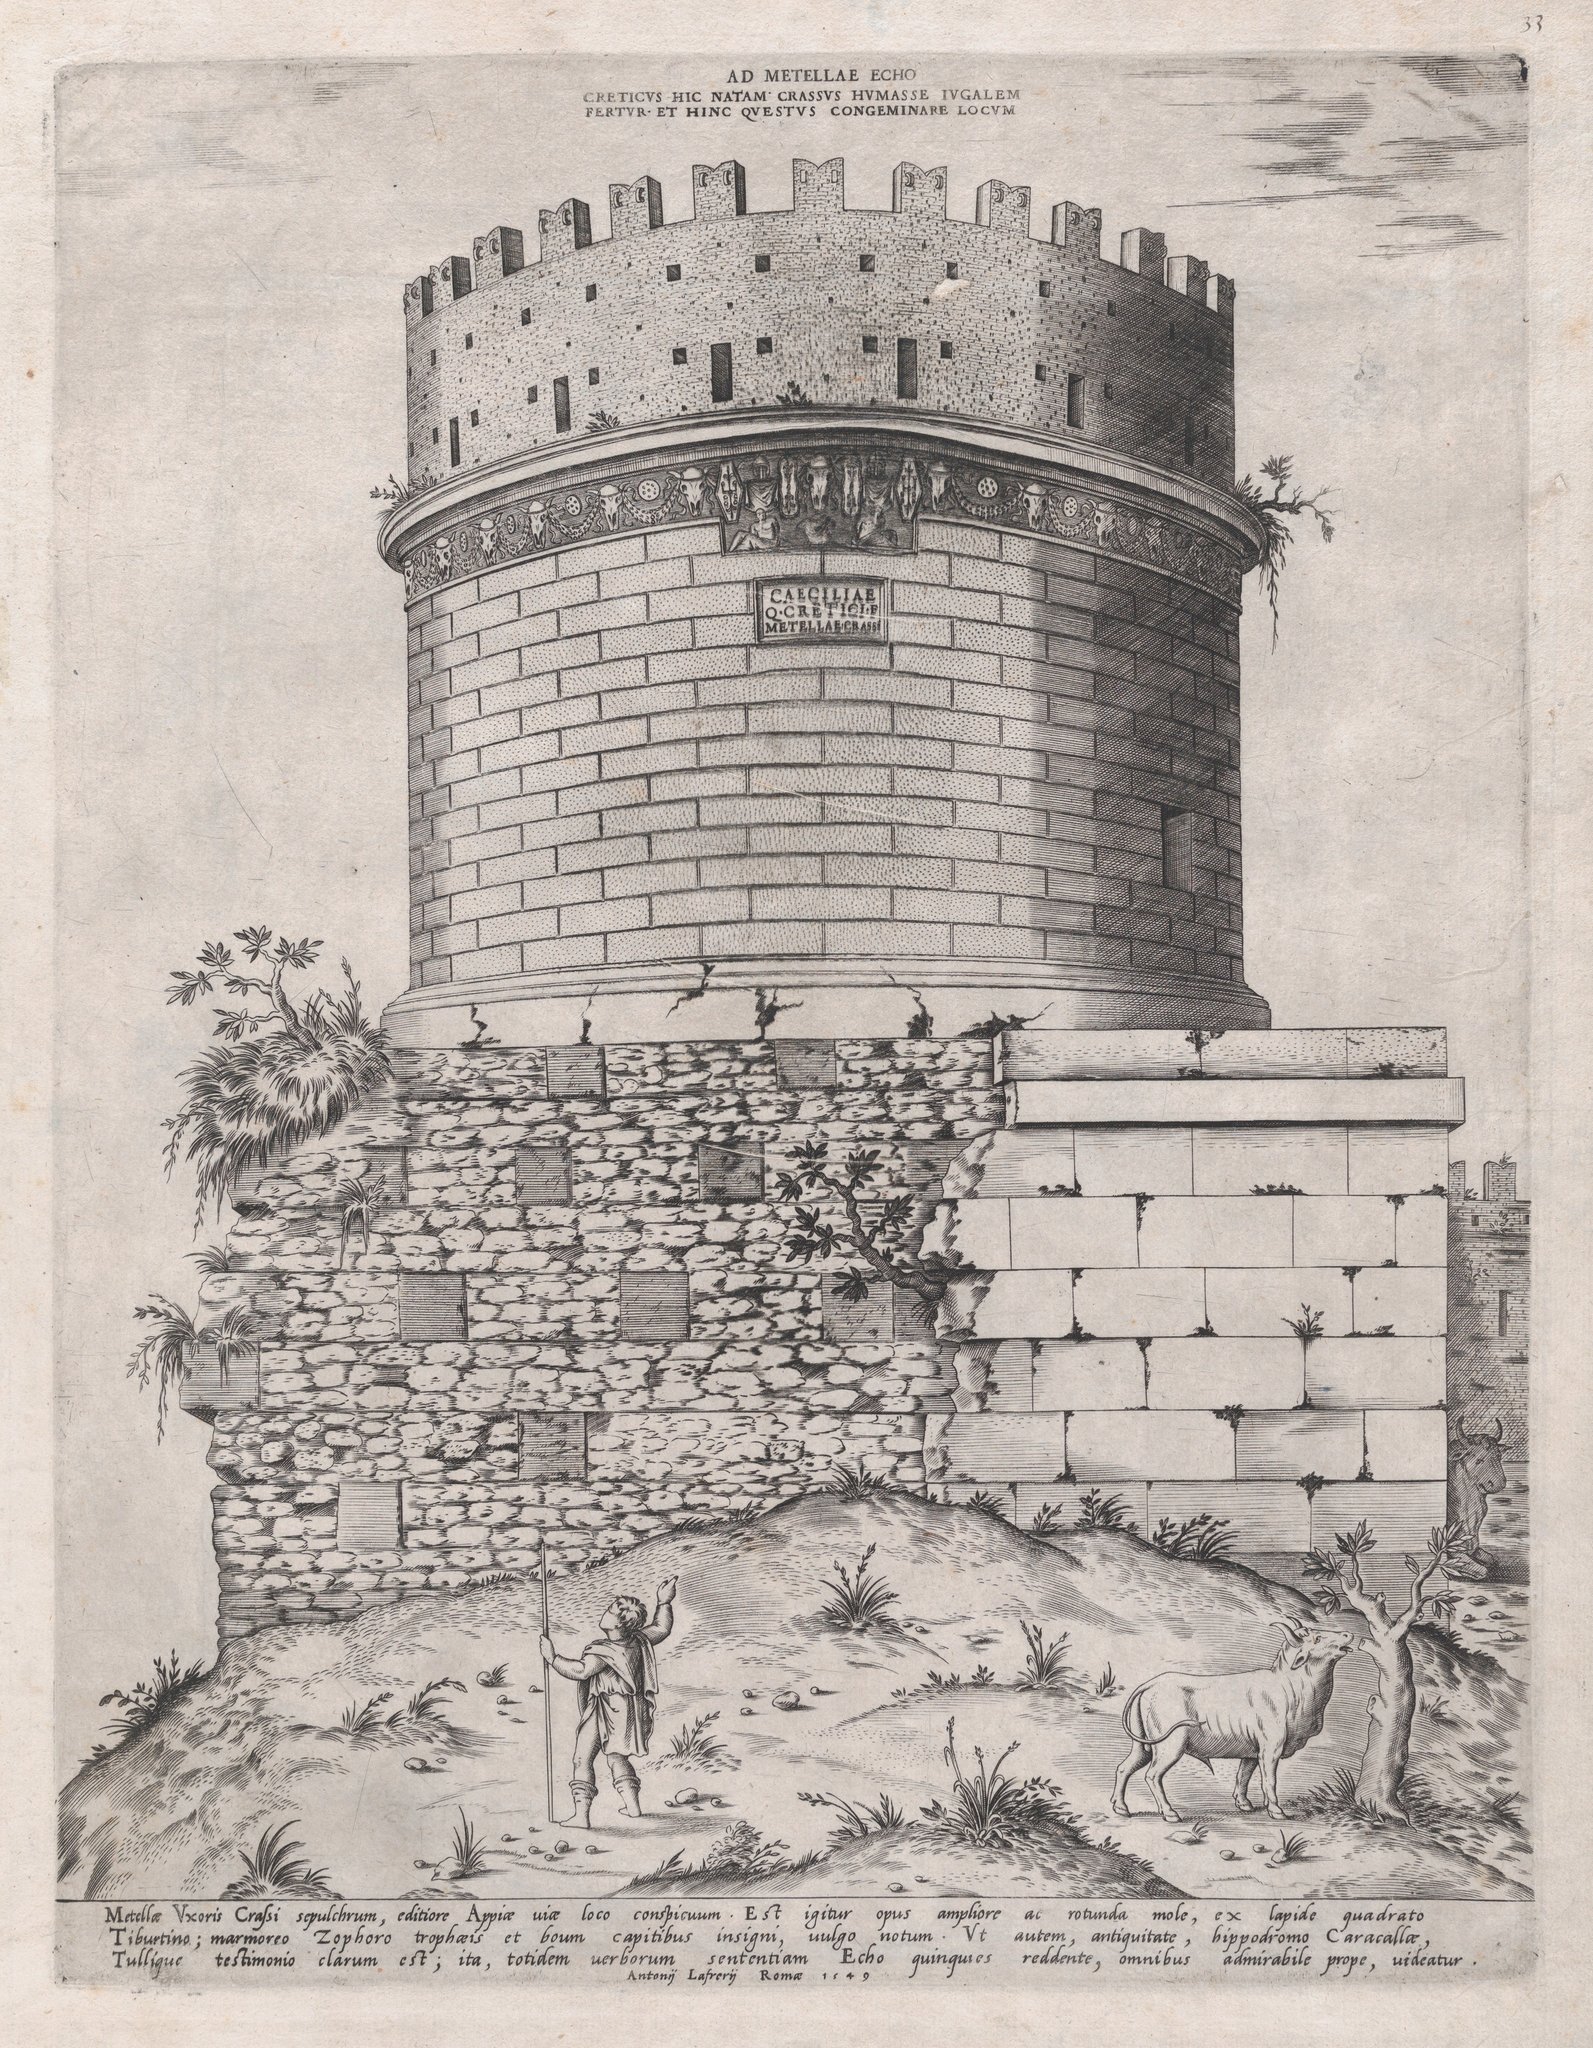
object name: print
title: Sepulchre of Metella, from "Speculum Romanae Magnificentiae"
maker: Anonymous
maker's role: artist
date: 1549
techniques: engraving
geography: rome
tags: tombs,rome